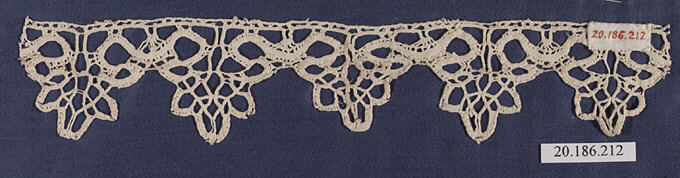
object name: edging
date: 1601-1700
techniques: lace